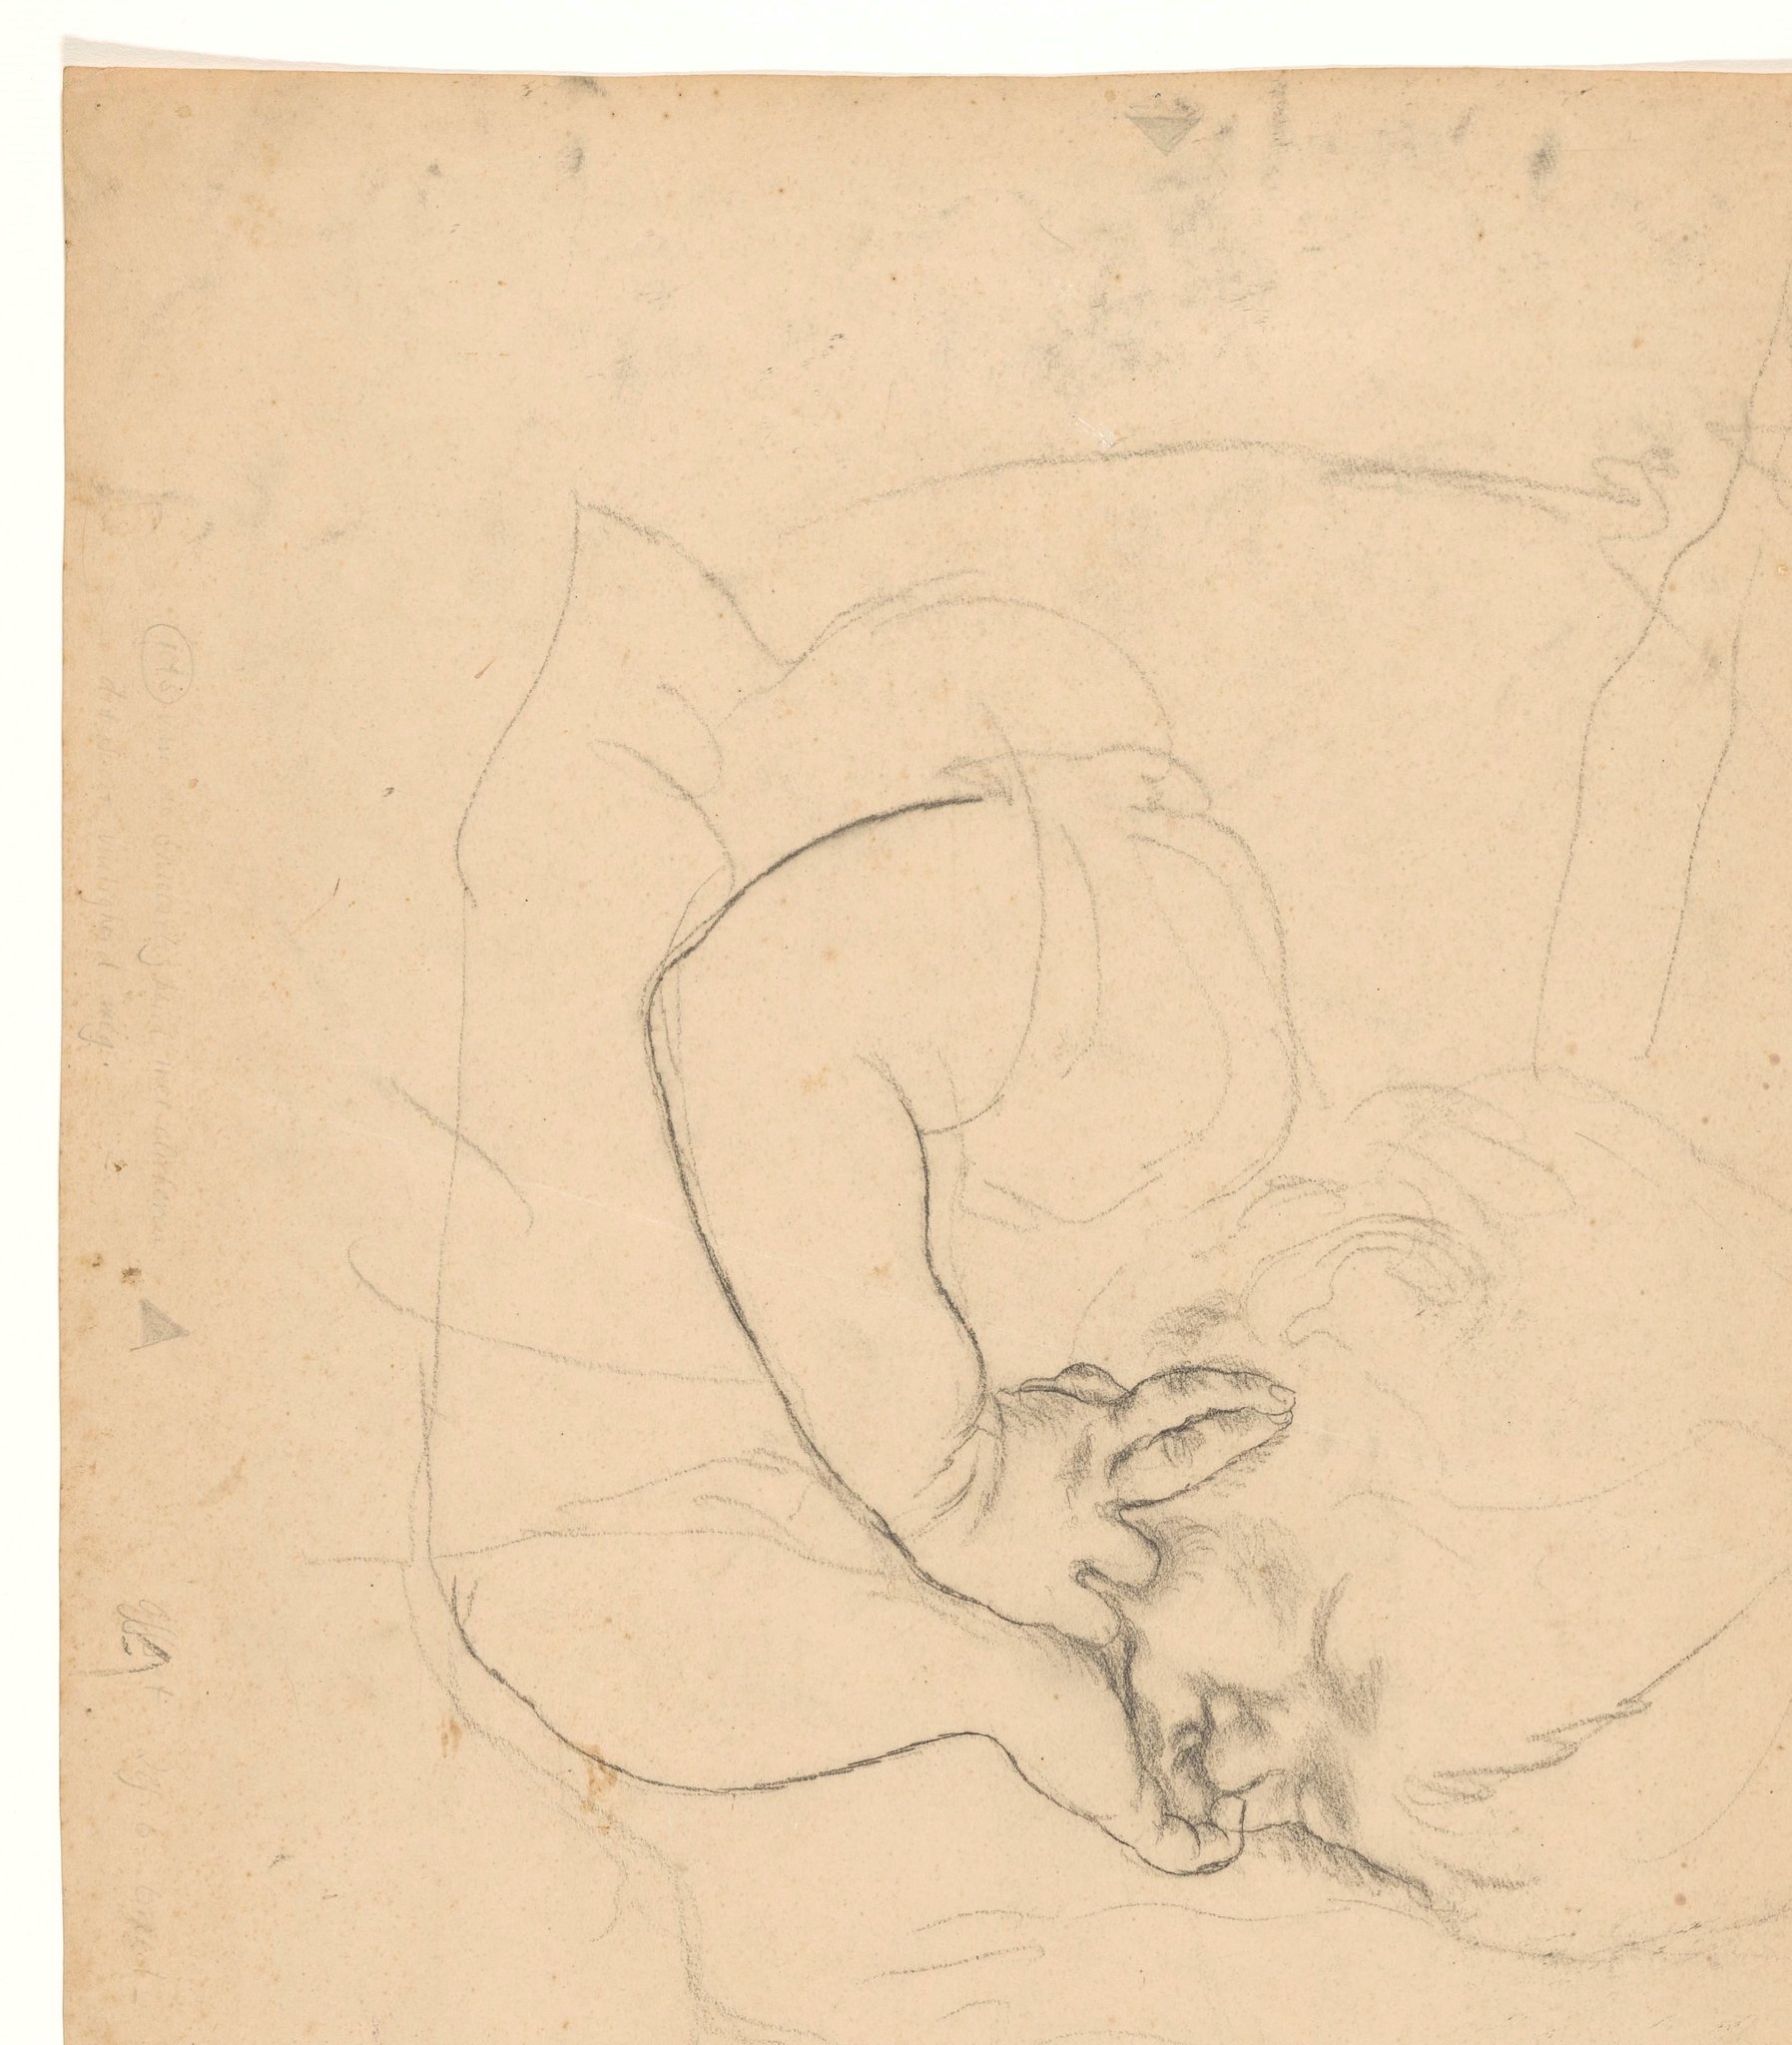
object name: drawing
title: Slapend kind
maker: henk henriët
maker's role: draughtsman, print maker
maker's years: 1903-1945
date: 1913-1945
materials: chalk, paper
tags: sleeping; unconsciousness, child (at home)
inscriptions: : ‘iets van de snoezeligheid met clicheren / [...]’, collector's mark: Lugt 2228